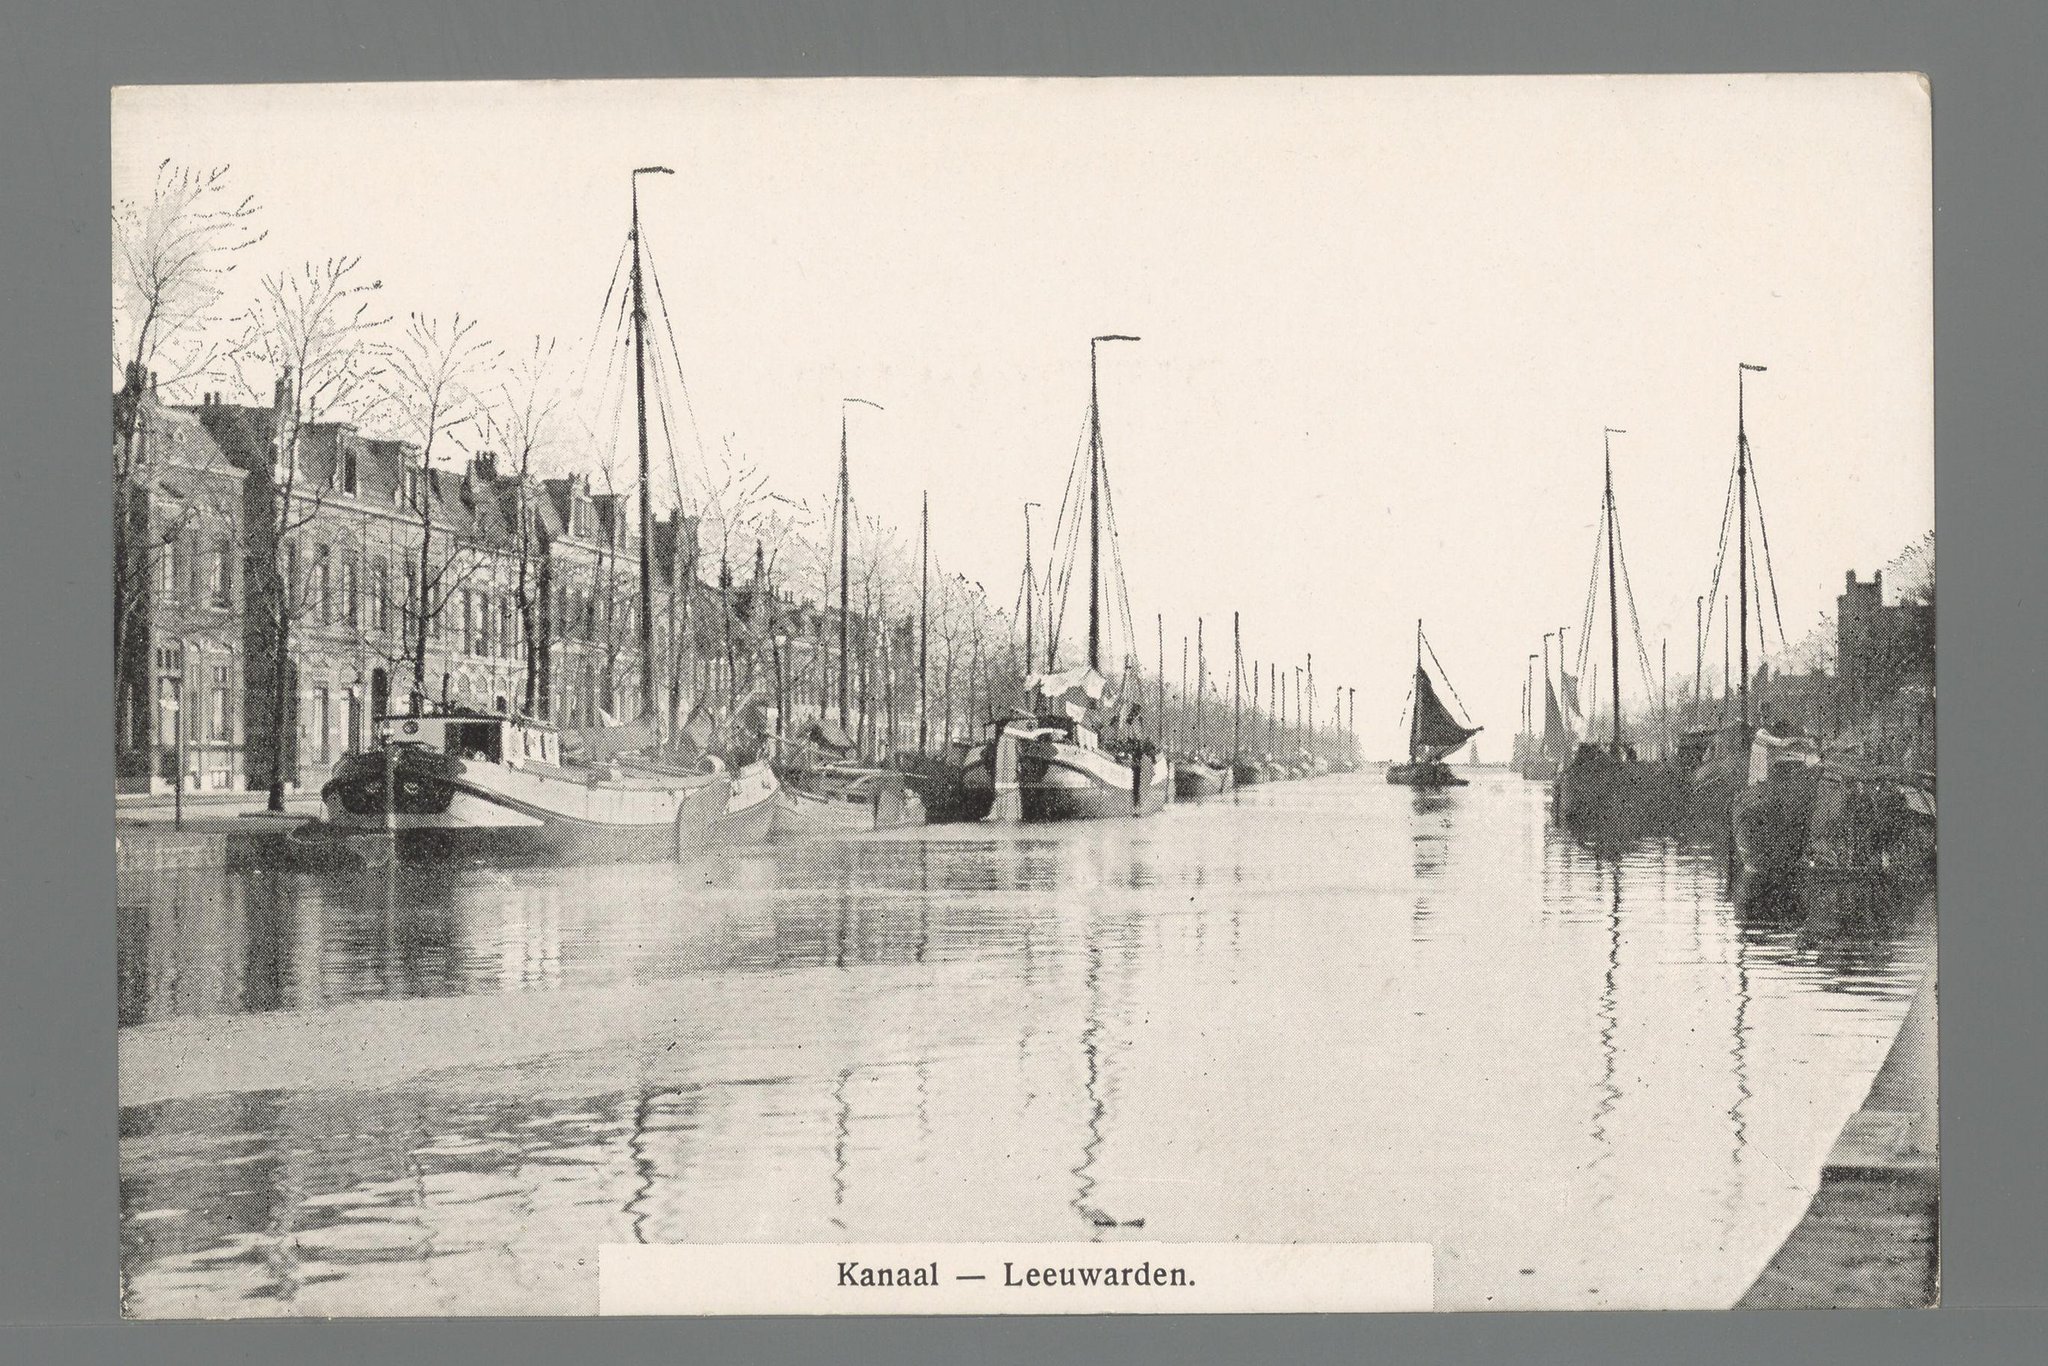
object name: ansichtkaart, prentbriefkaart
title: Kanaal - Leeuwarden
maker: Anonymous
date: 1905-1930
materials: cardboard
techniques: autotype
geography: leeuwarden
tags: city-view, and landscape with man-made constructions, sailing-ship, sailing-boat, canal